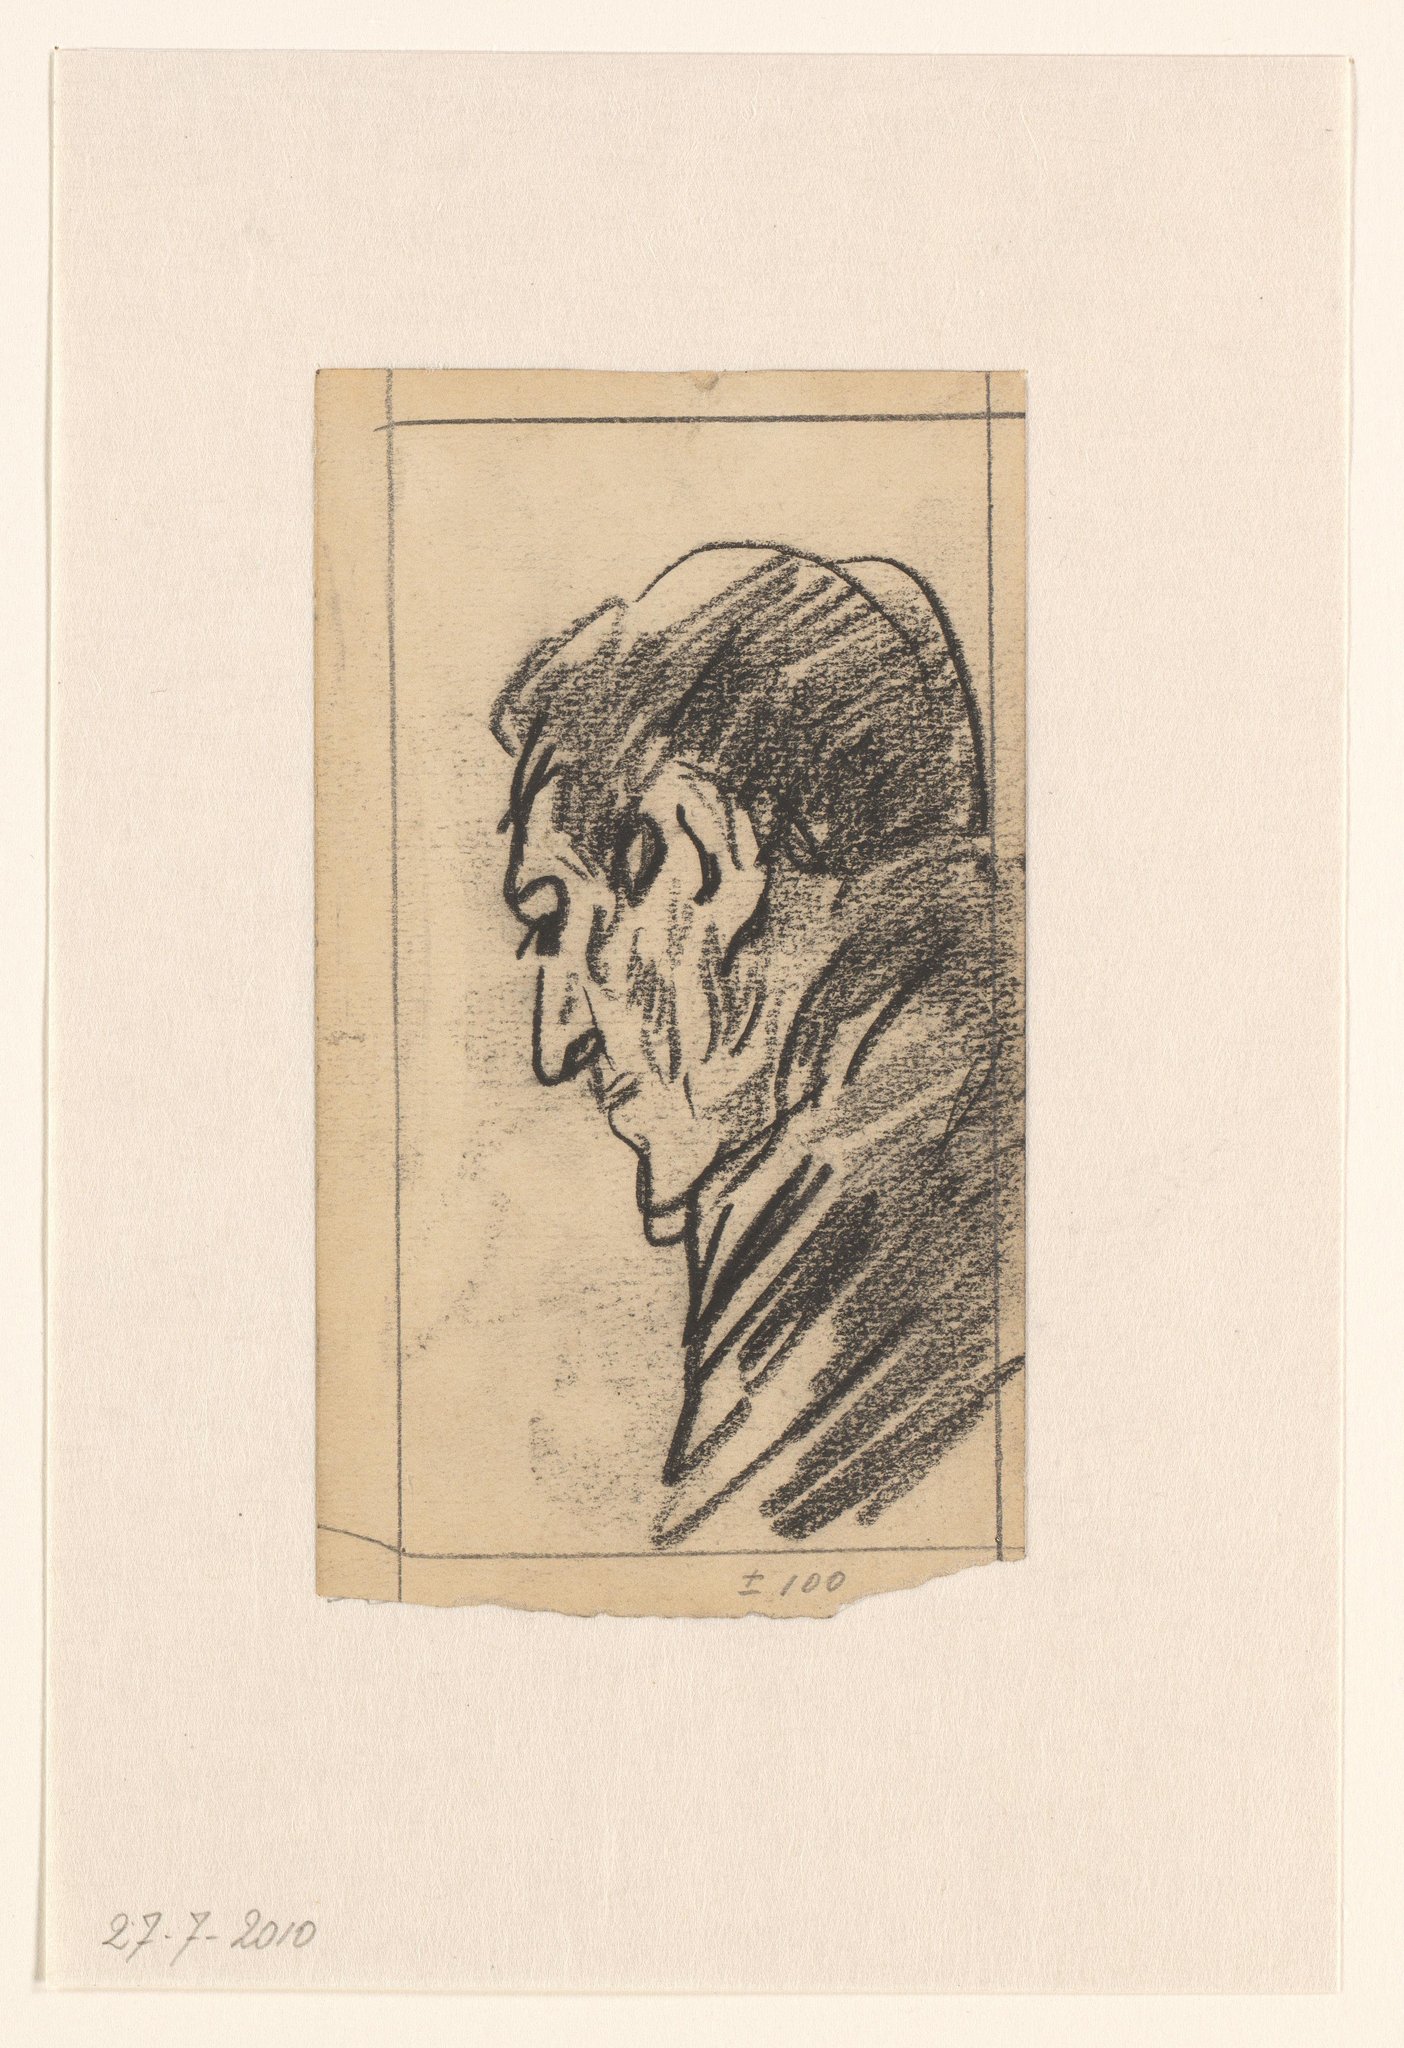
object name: drawing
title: Manskop, naar links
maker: jan veth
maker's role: designer, draughtsman, painter, print maker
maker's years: 1864-1925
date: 1874-1925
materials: chalk, paper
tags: anonymous historical person portrayed alone